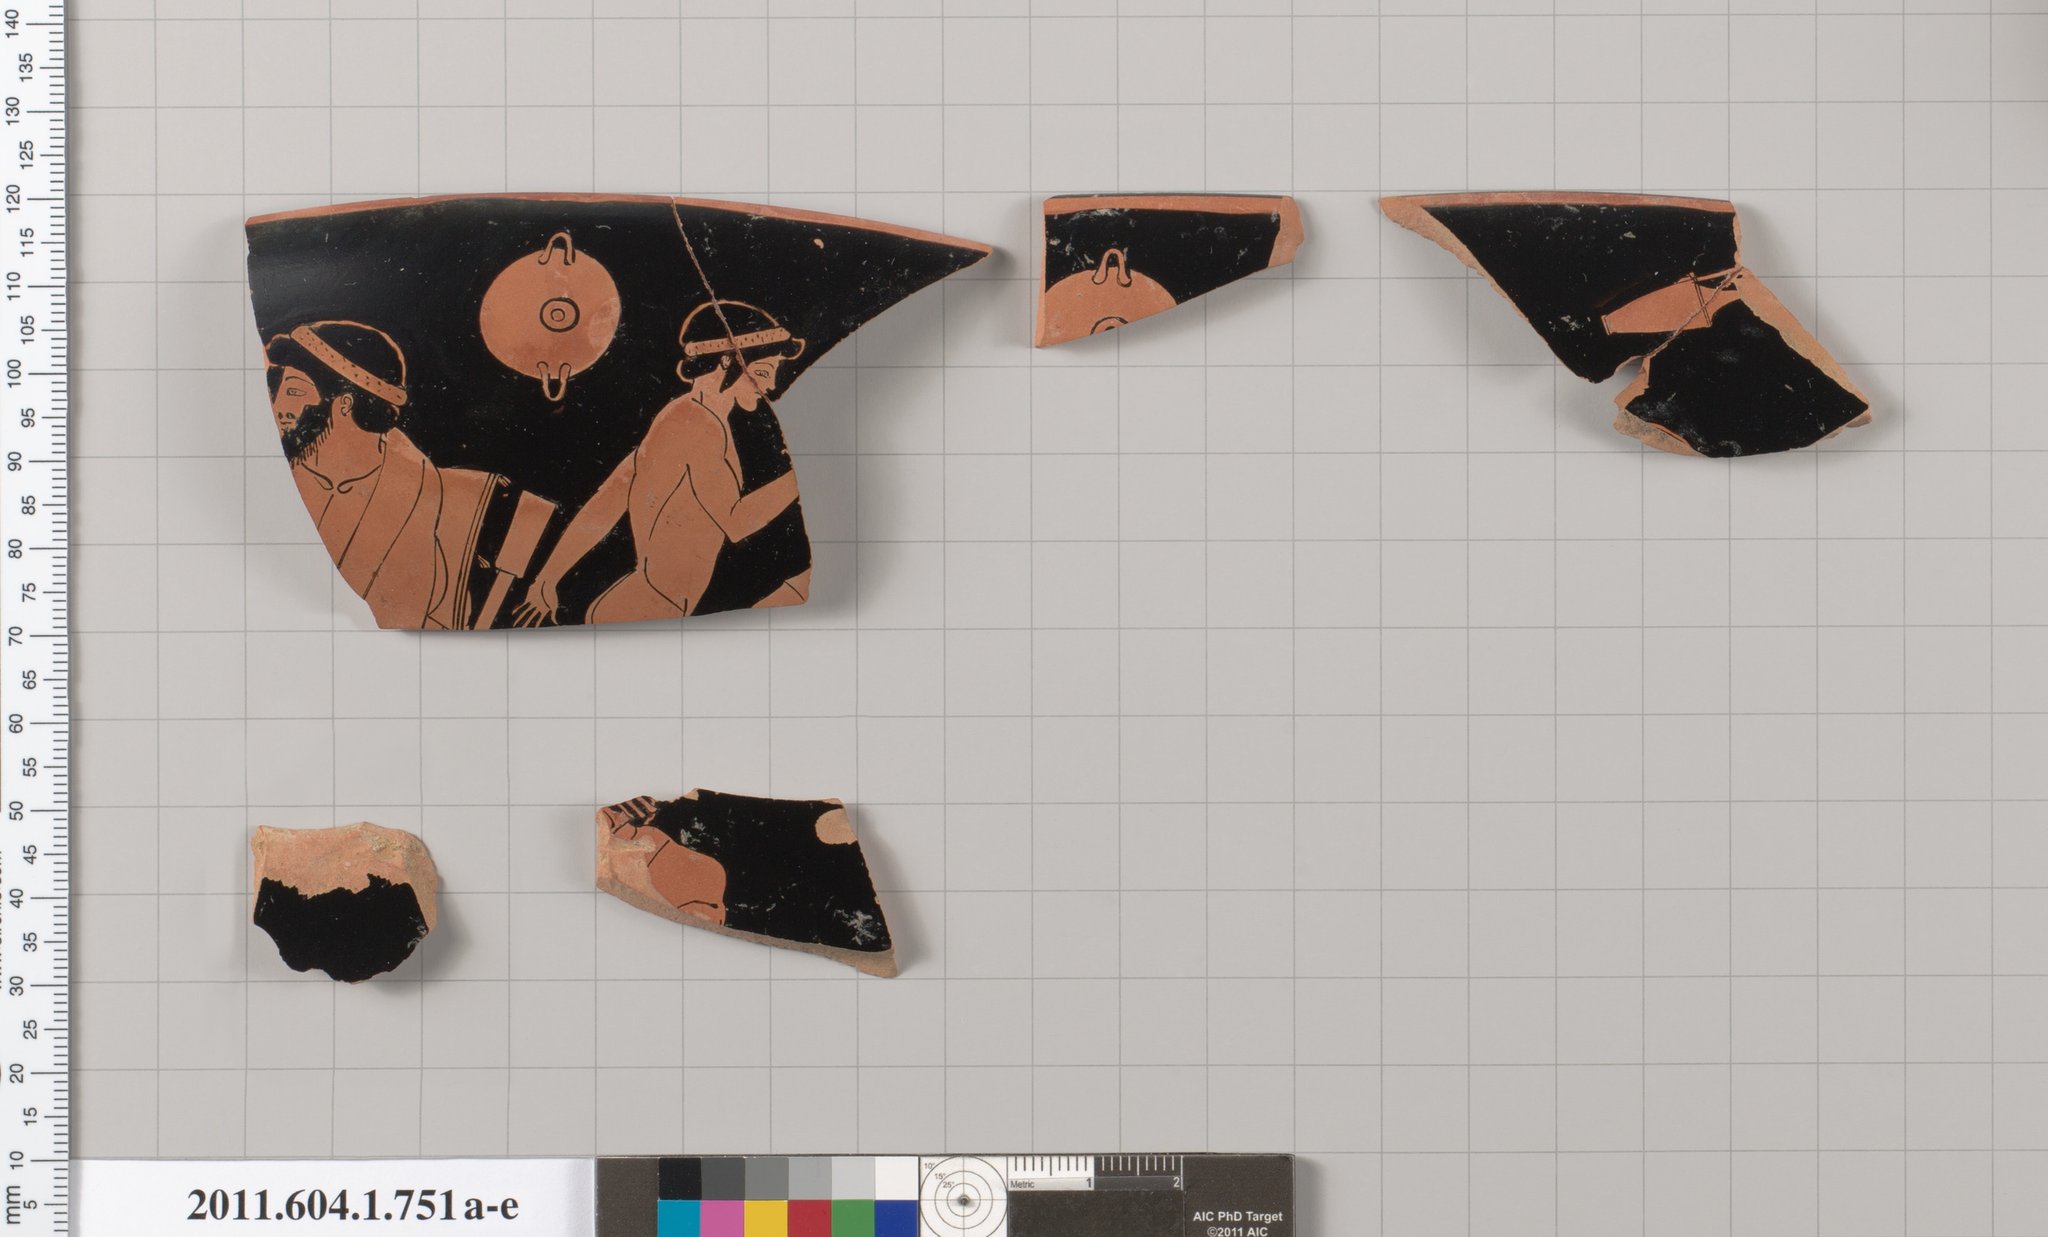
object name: kylix fragment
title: Terracotta fragments of a kylix (drinking cup)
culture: greek, attic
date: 490-480 BCE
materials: terracotta